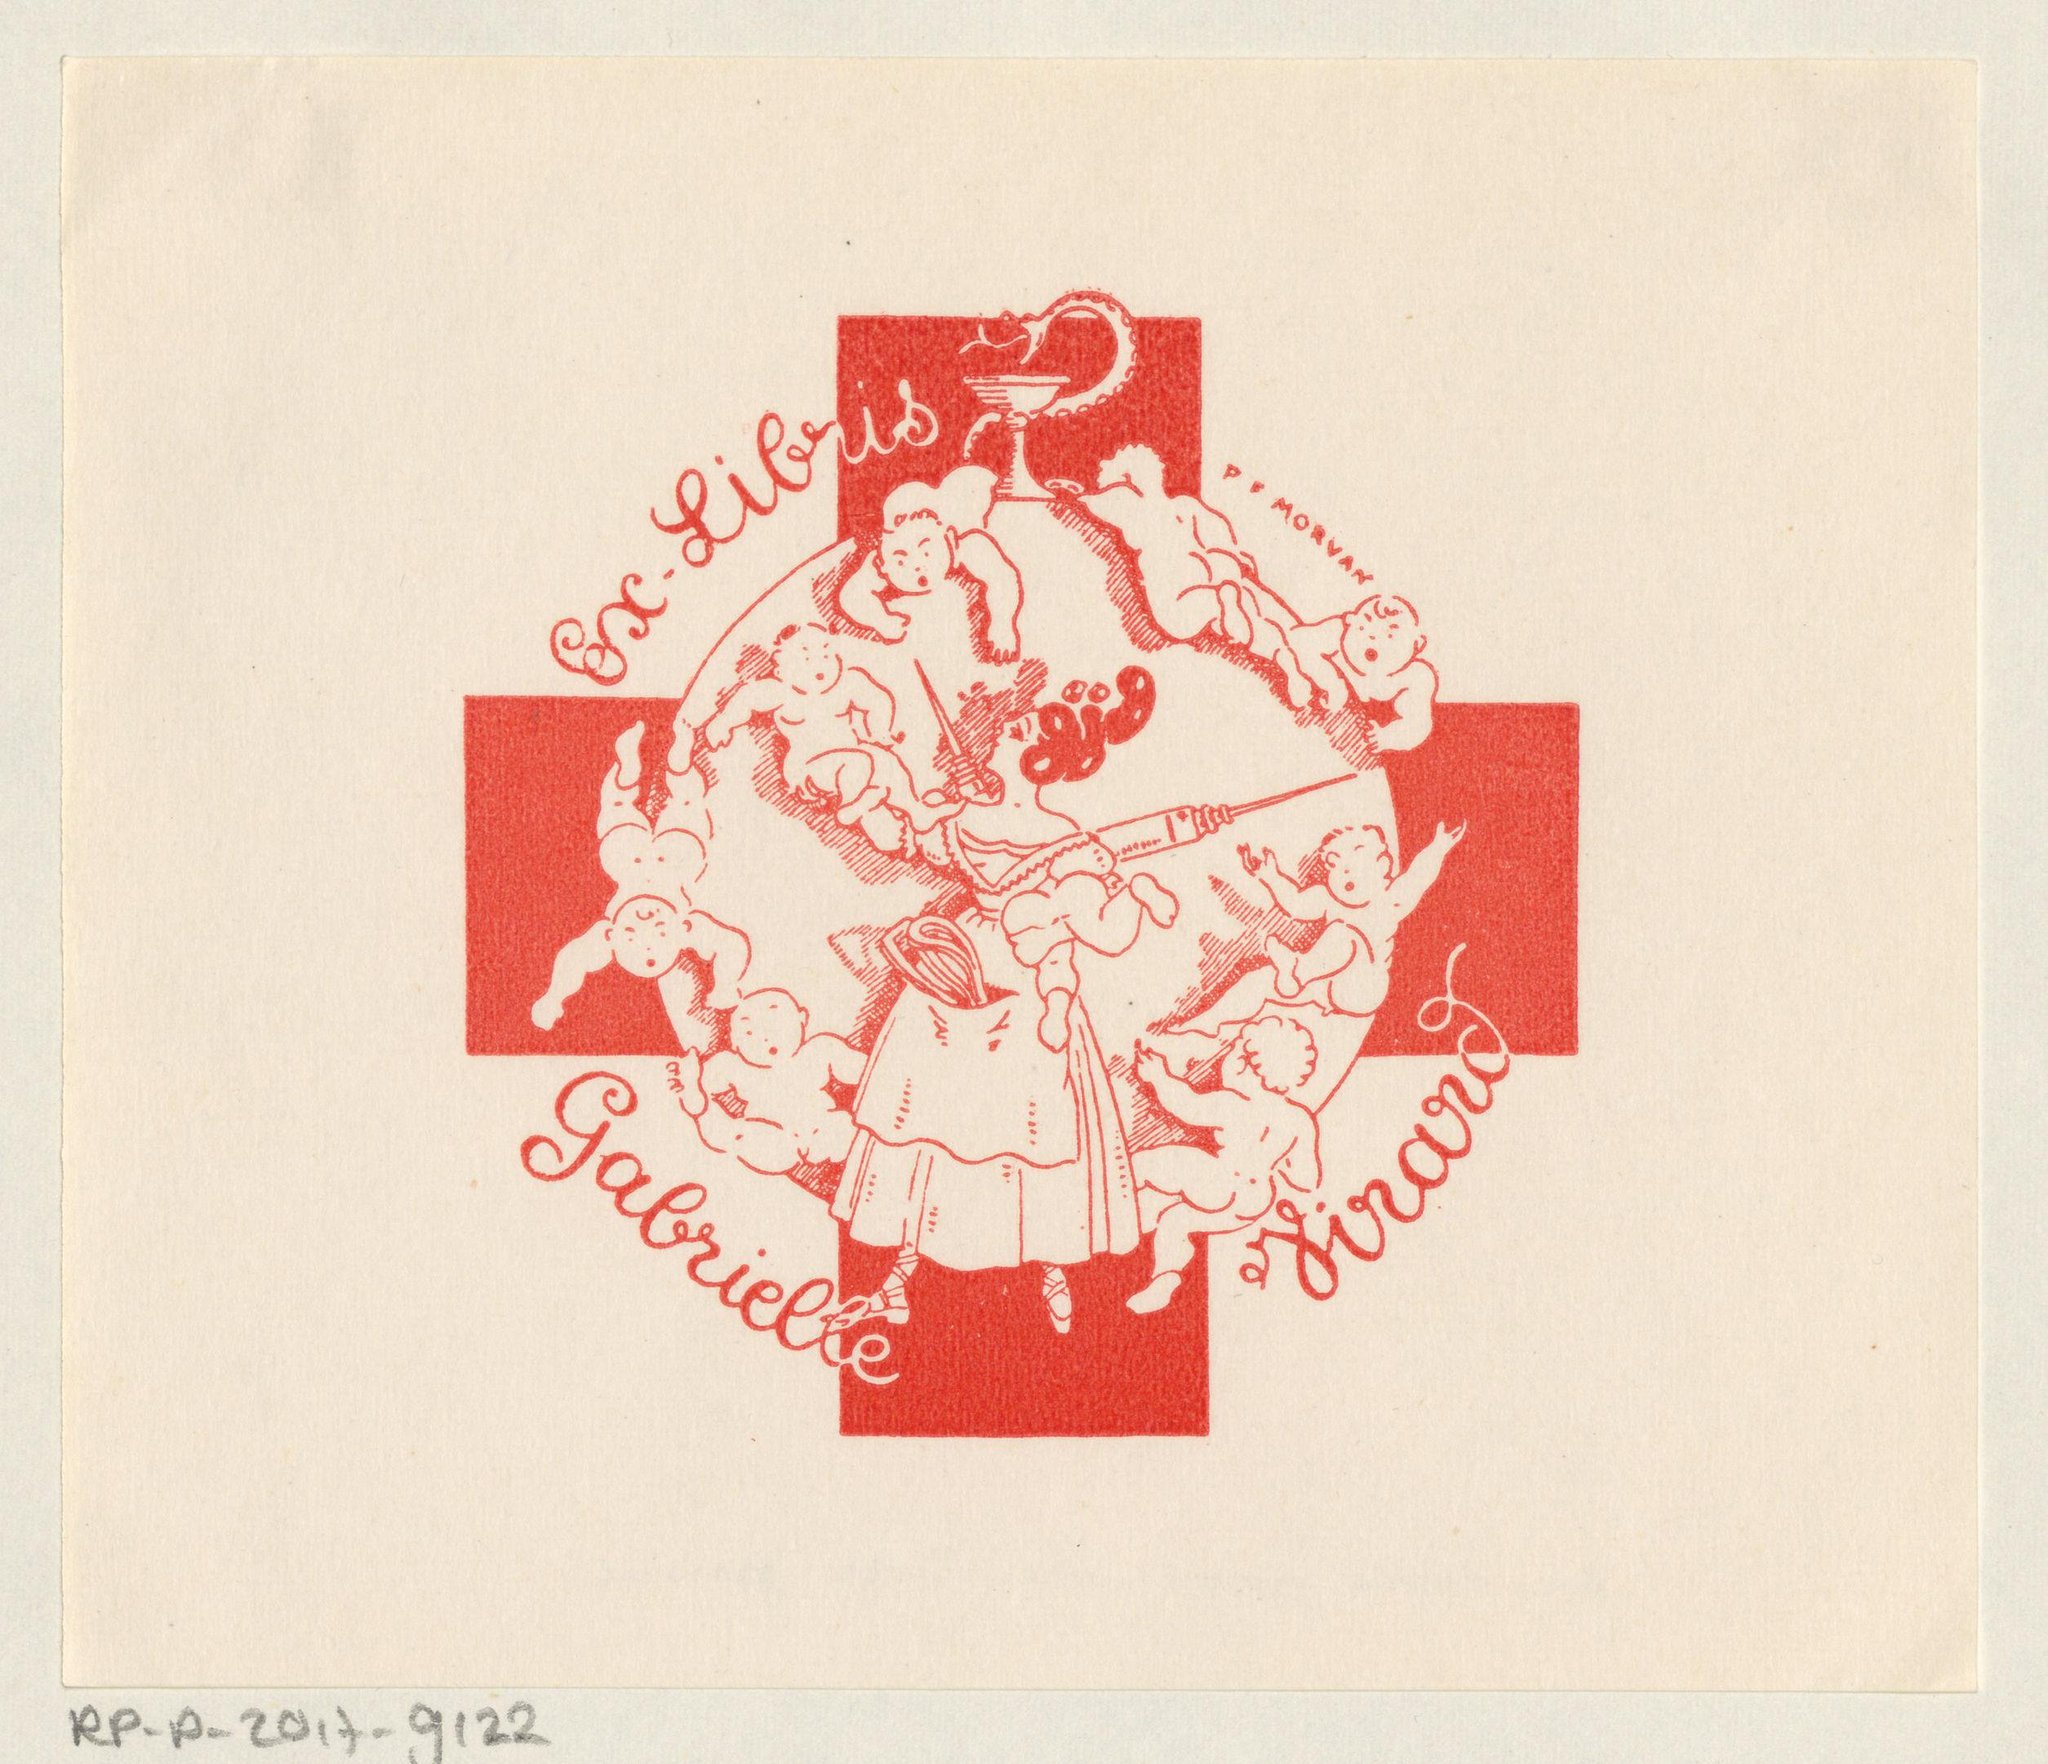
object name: bookplate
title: Ex libris van Gabrielle Virard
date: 1900-1999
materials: paper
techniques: printing block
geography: france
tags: nurse ~ hospital, injection ~ medicine, infant, baby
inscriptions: inscription: ‘ex-libris pour une sage-femme’